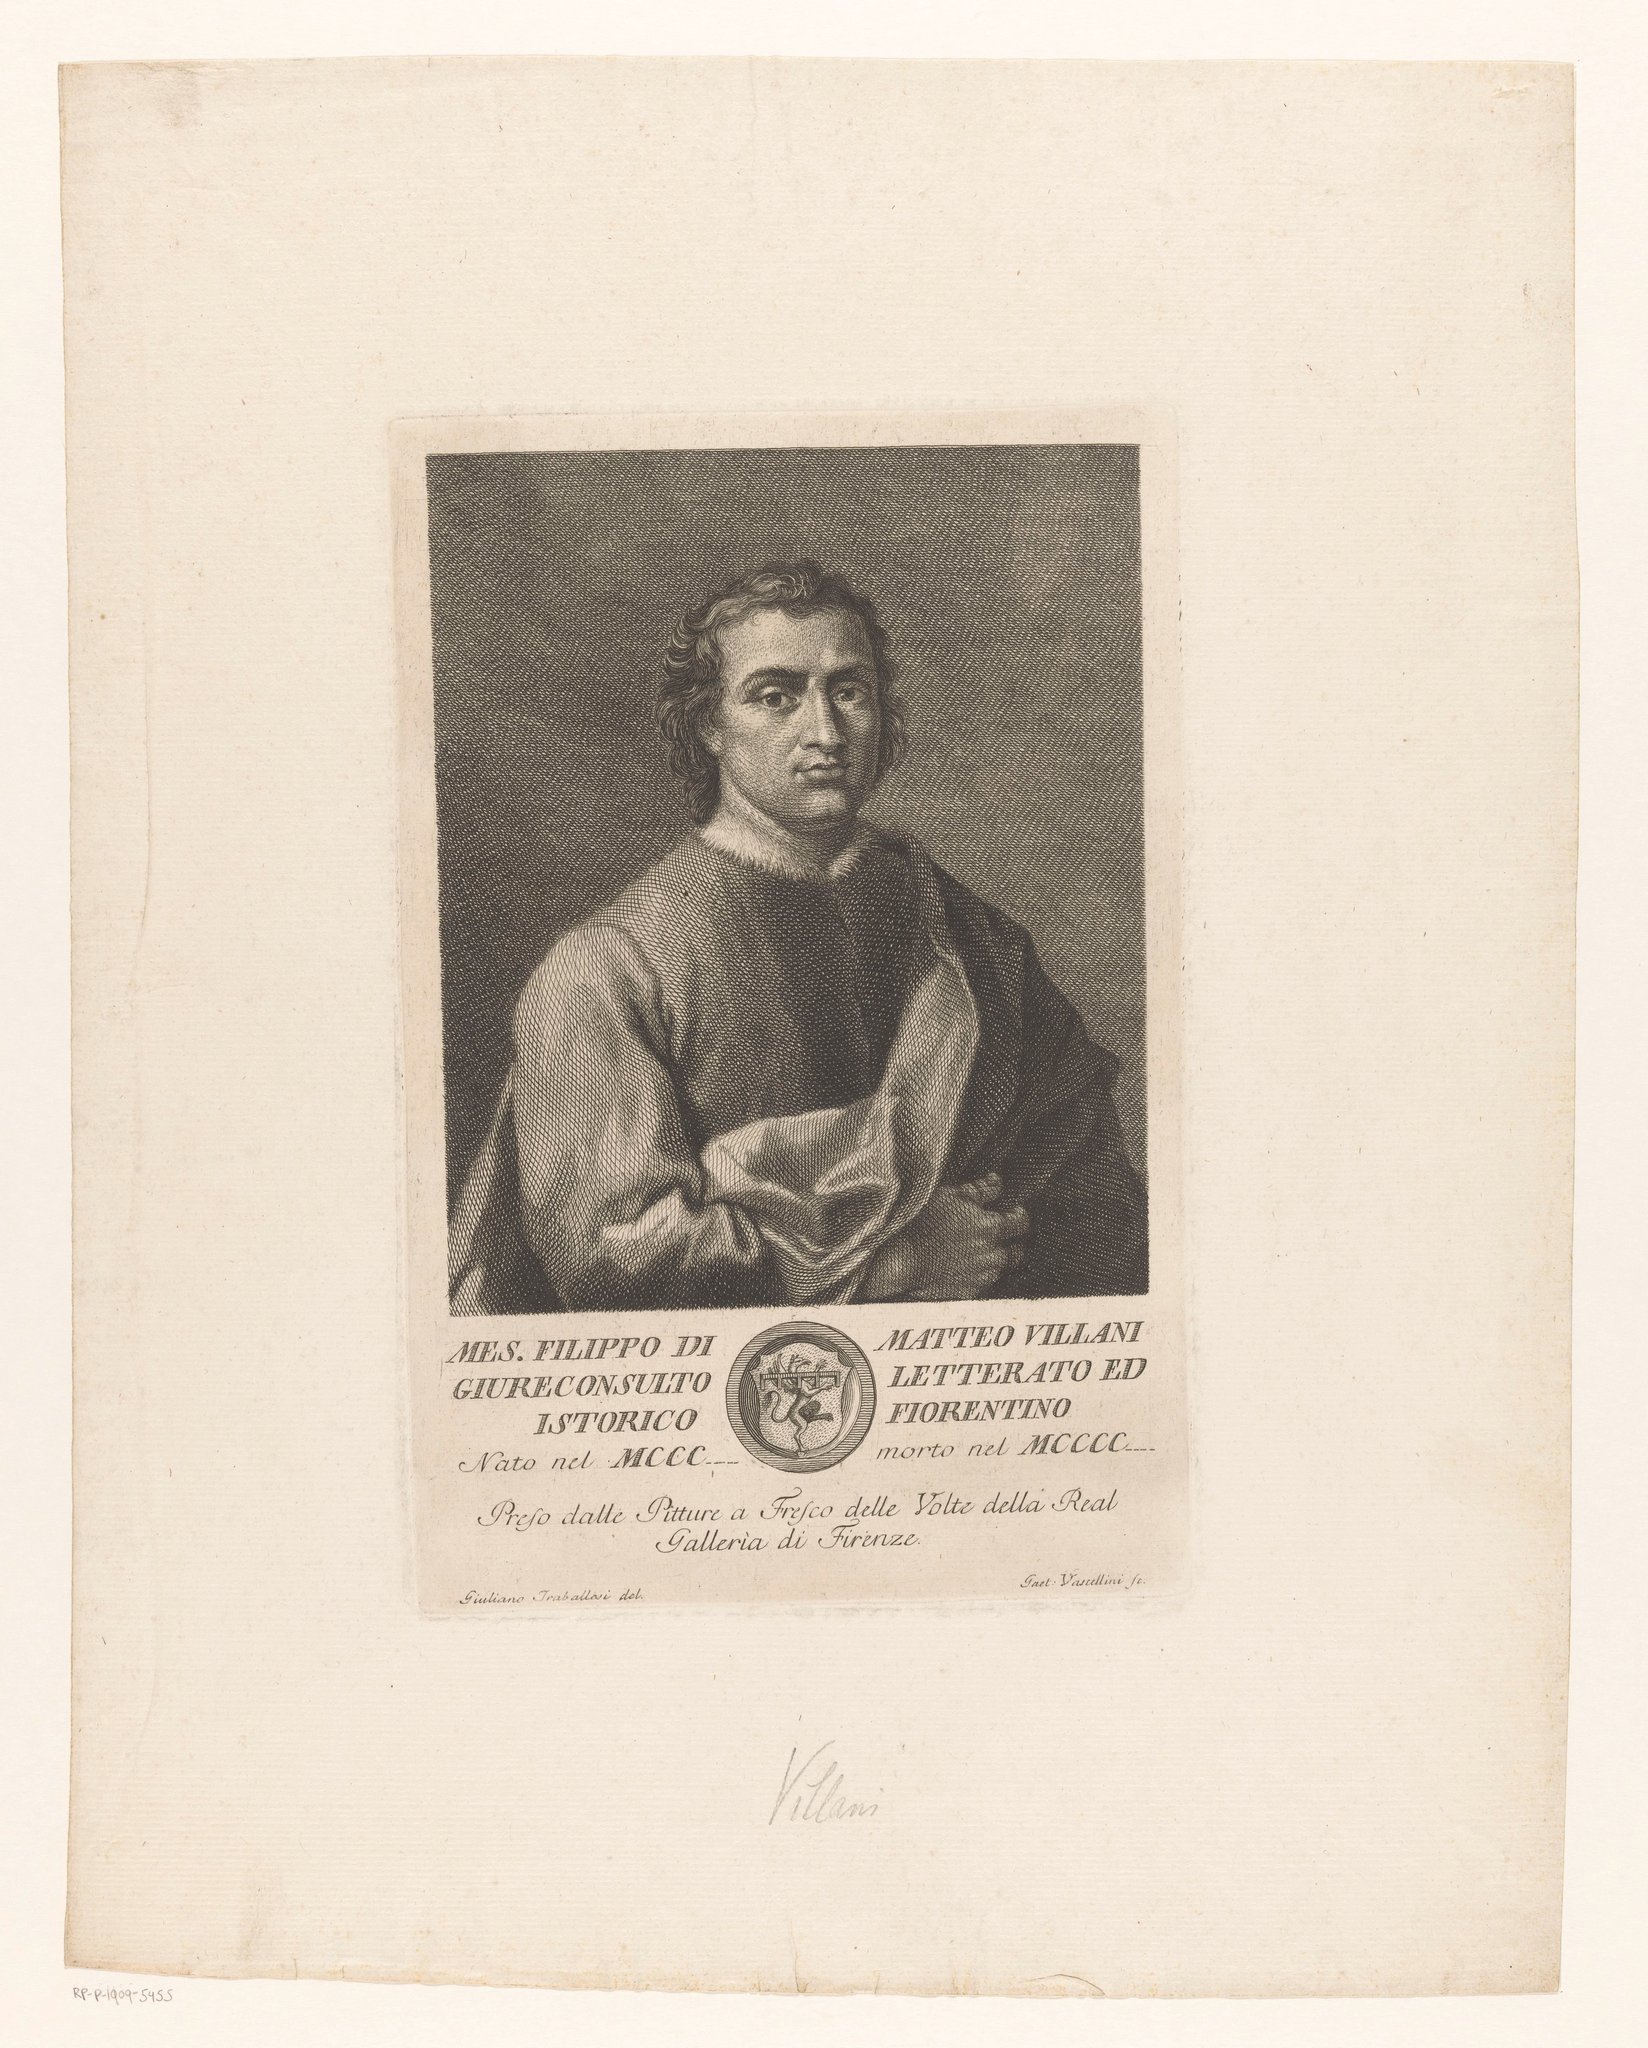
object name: print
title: Portret van schrijver en historicus Filippo Villani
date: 1755-1805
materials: paper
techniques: engraving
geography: italy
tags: historical persons, portrait of a writer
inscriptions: collector's mark: Lugt 2228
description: Onder het portret een tekst in het Italiaans en een wapenschild in een cirkelvormig kader.